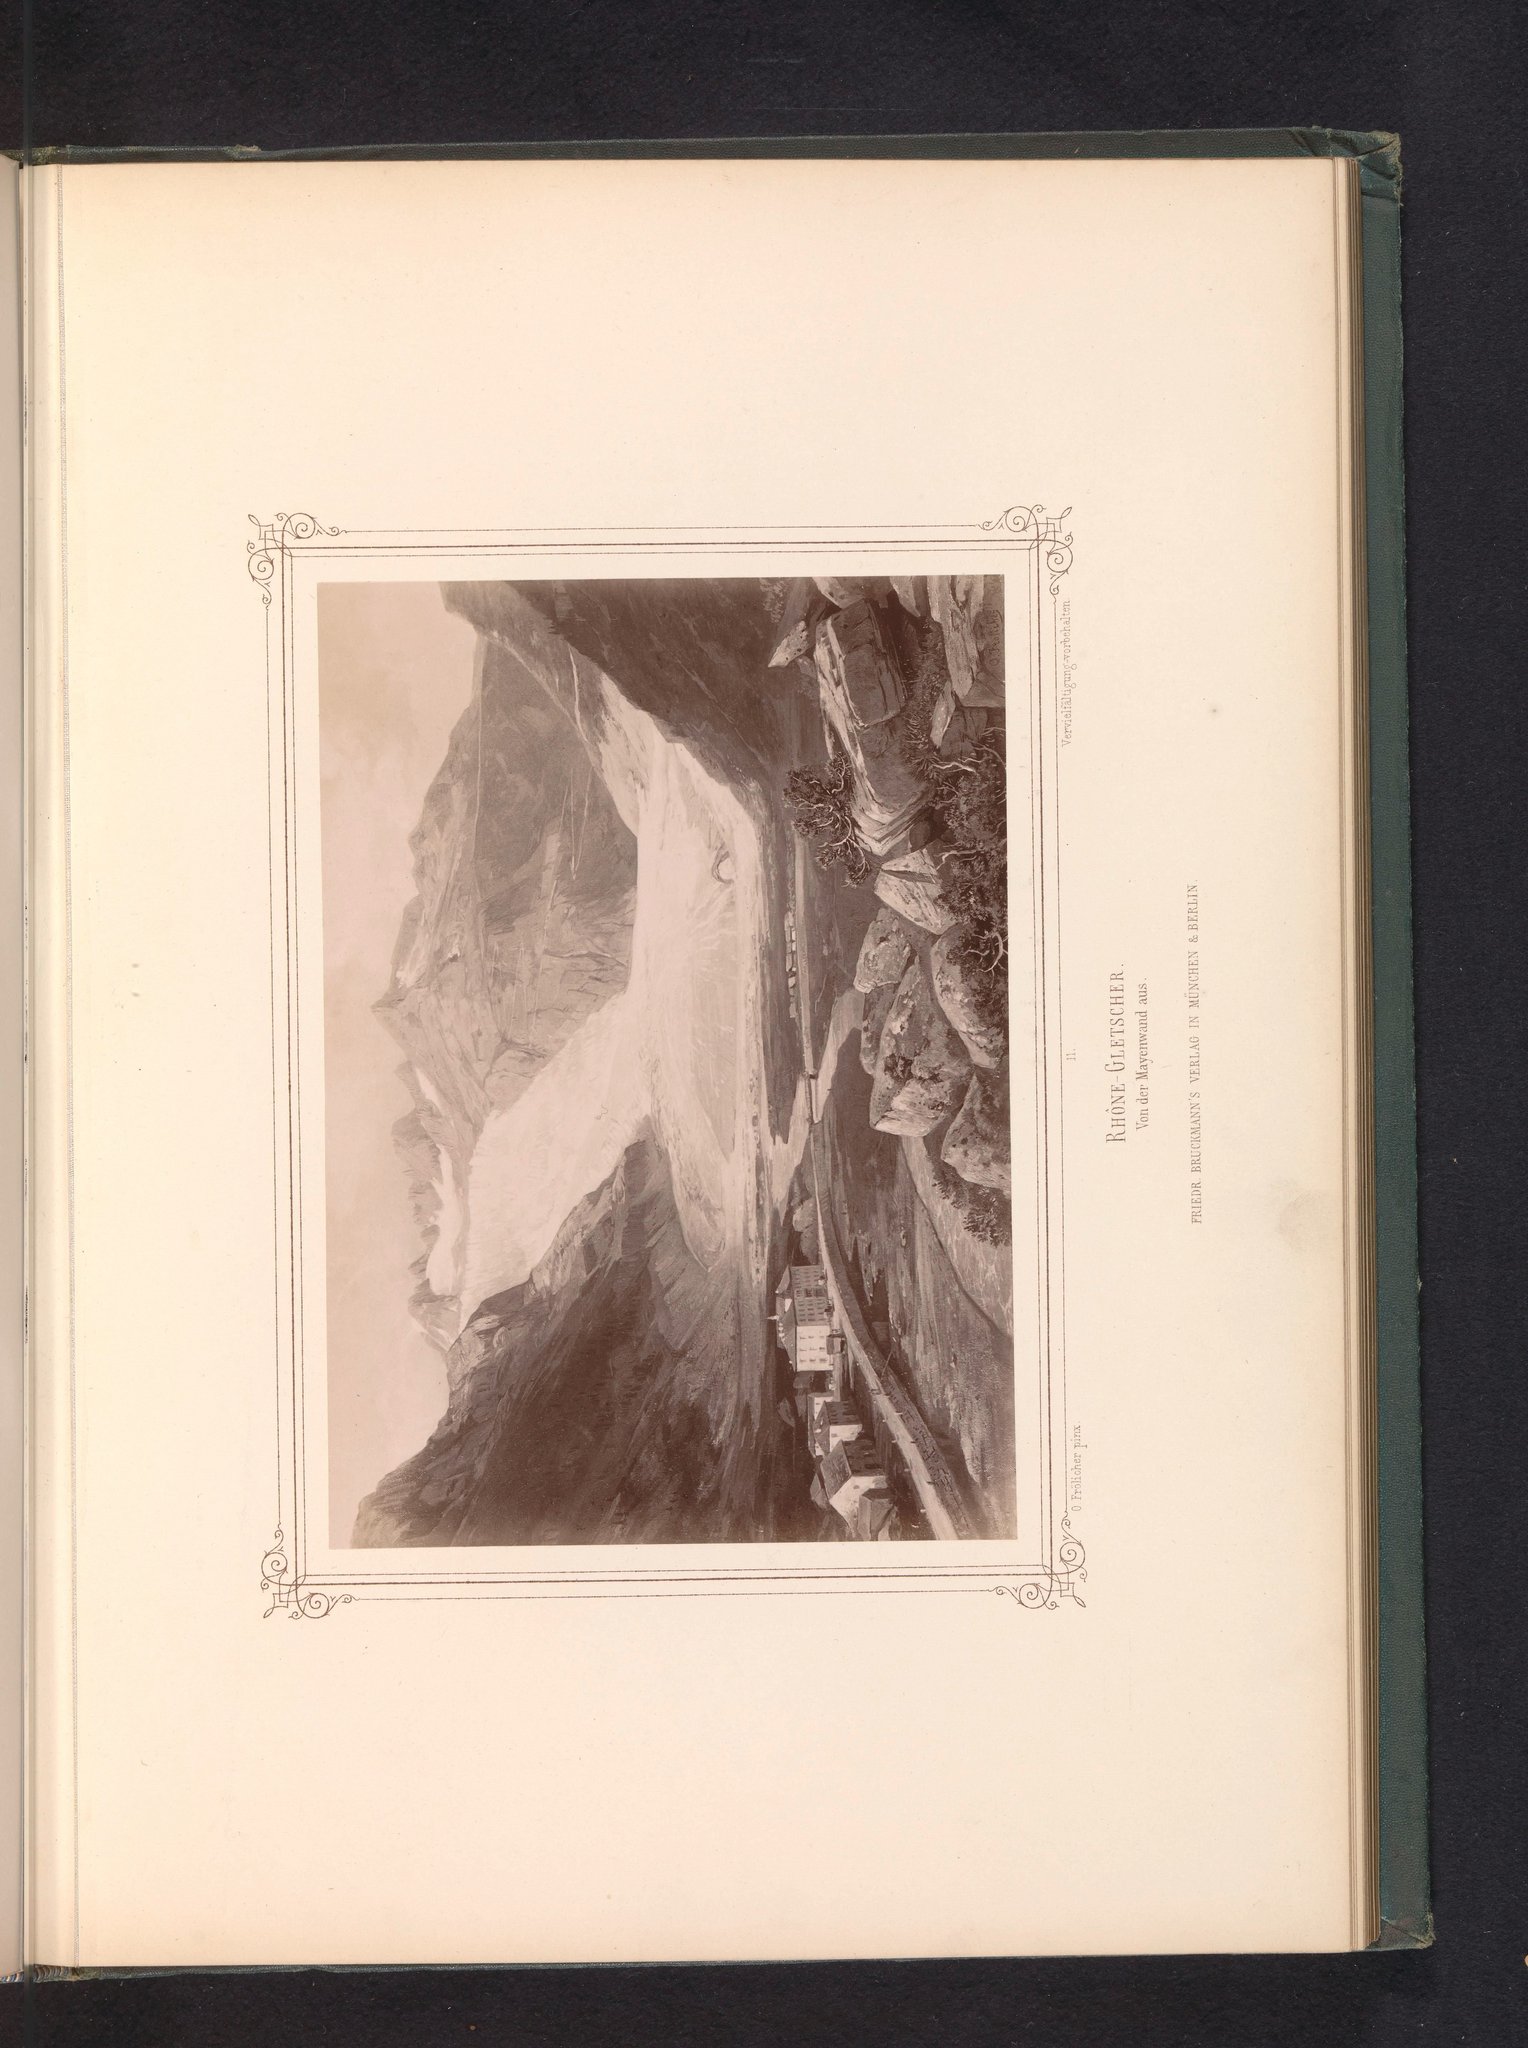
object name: page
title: Fotoreproductie van een schilderij van de Rhônegletsjer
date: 1863-1873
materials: photographic support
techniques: albumen print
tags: glacier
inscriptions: number: ‘11.’